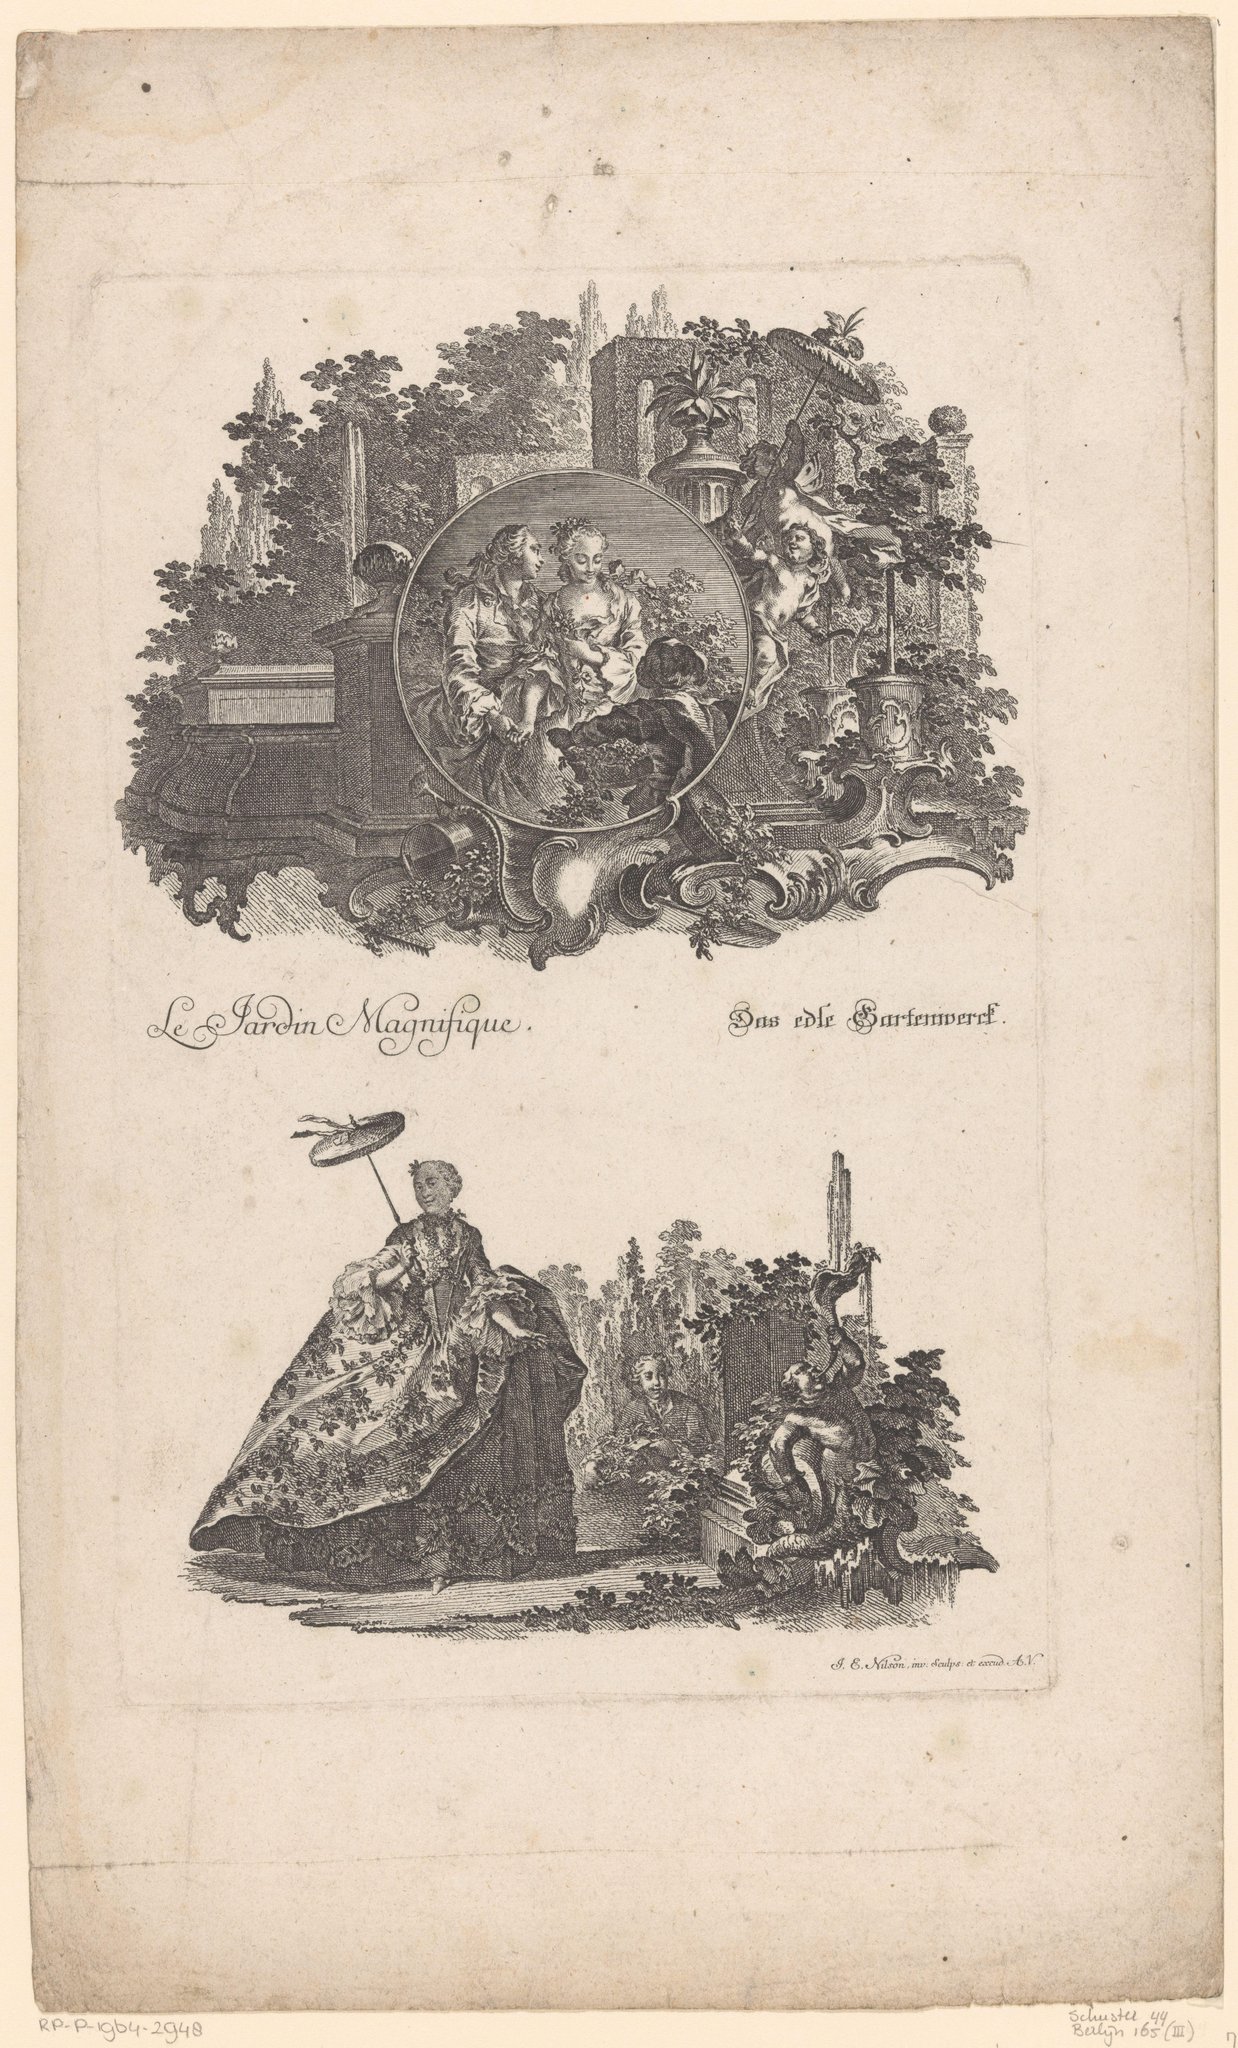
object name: ornament print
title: Man koopt bloemen voor zijn geliefde en een vrouw in een tuin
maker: johann esaias nilson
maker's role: draughtsman, print maker, publisher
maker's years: 1721-1788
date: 1731-1788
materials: paper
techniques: engraving, etching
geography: augsburg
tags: cut flowers; nosegay, bunch of flowers, garden, couple of lovers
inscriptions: collector's mark: Lugt 2228, collector's mark: Lugt 2760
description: Twee scènes op een blad. Boven: Een man koopt bloemen voor zijn geliefde van de jongen rechts voor hen. De voorstelling bevindt zich in een ronde lijst rustend op een rocaille ornament, in een tuin met putti en een fontein. Onder: Een vrouw met parasol loopt in een tuin met een fontein met putto. In de achtergrond een bediende met bloemenmand en een brief.